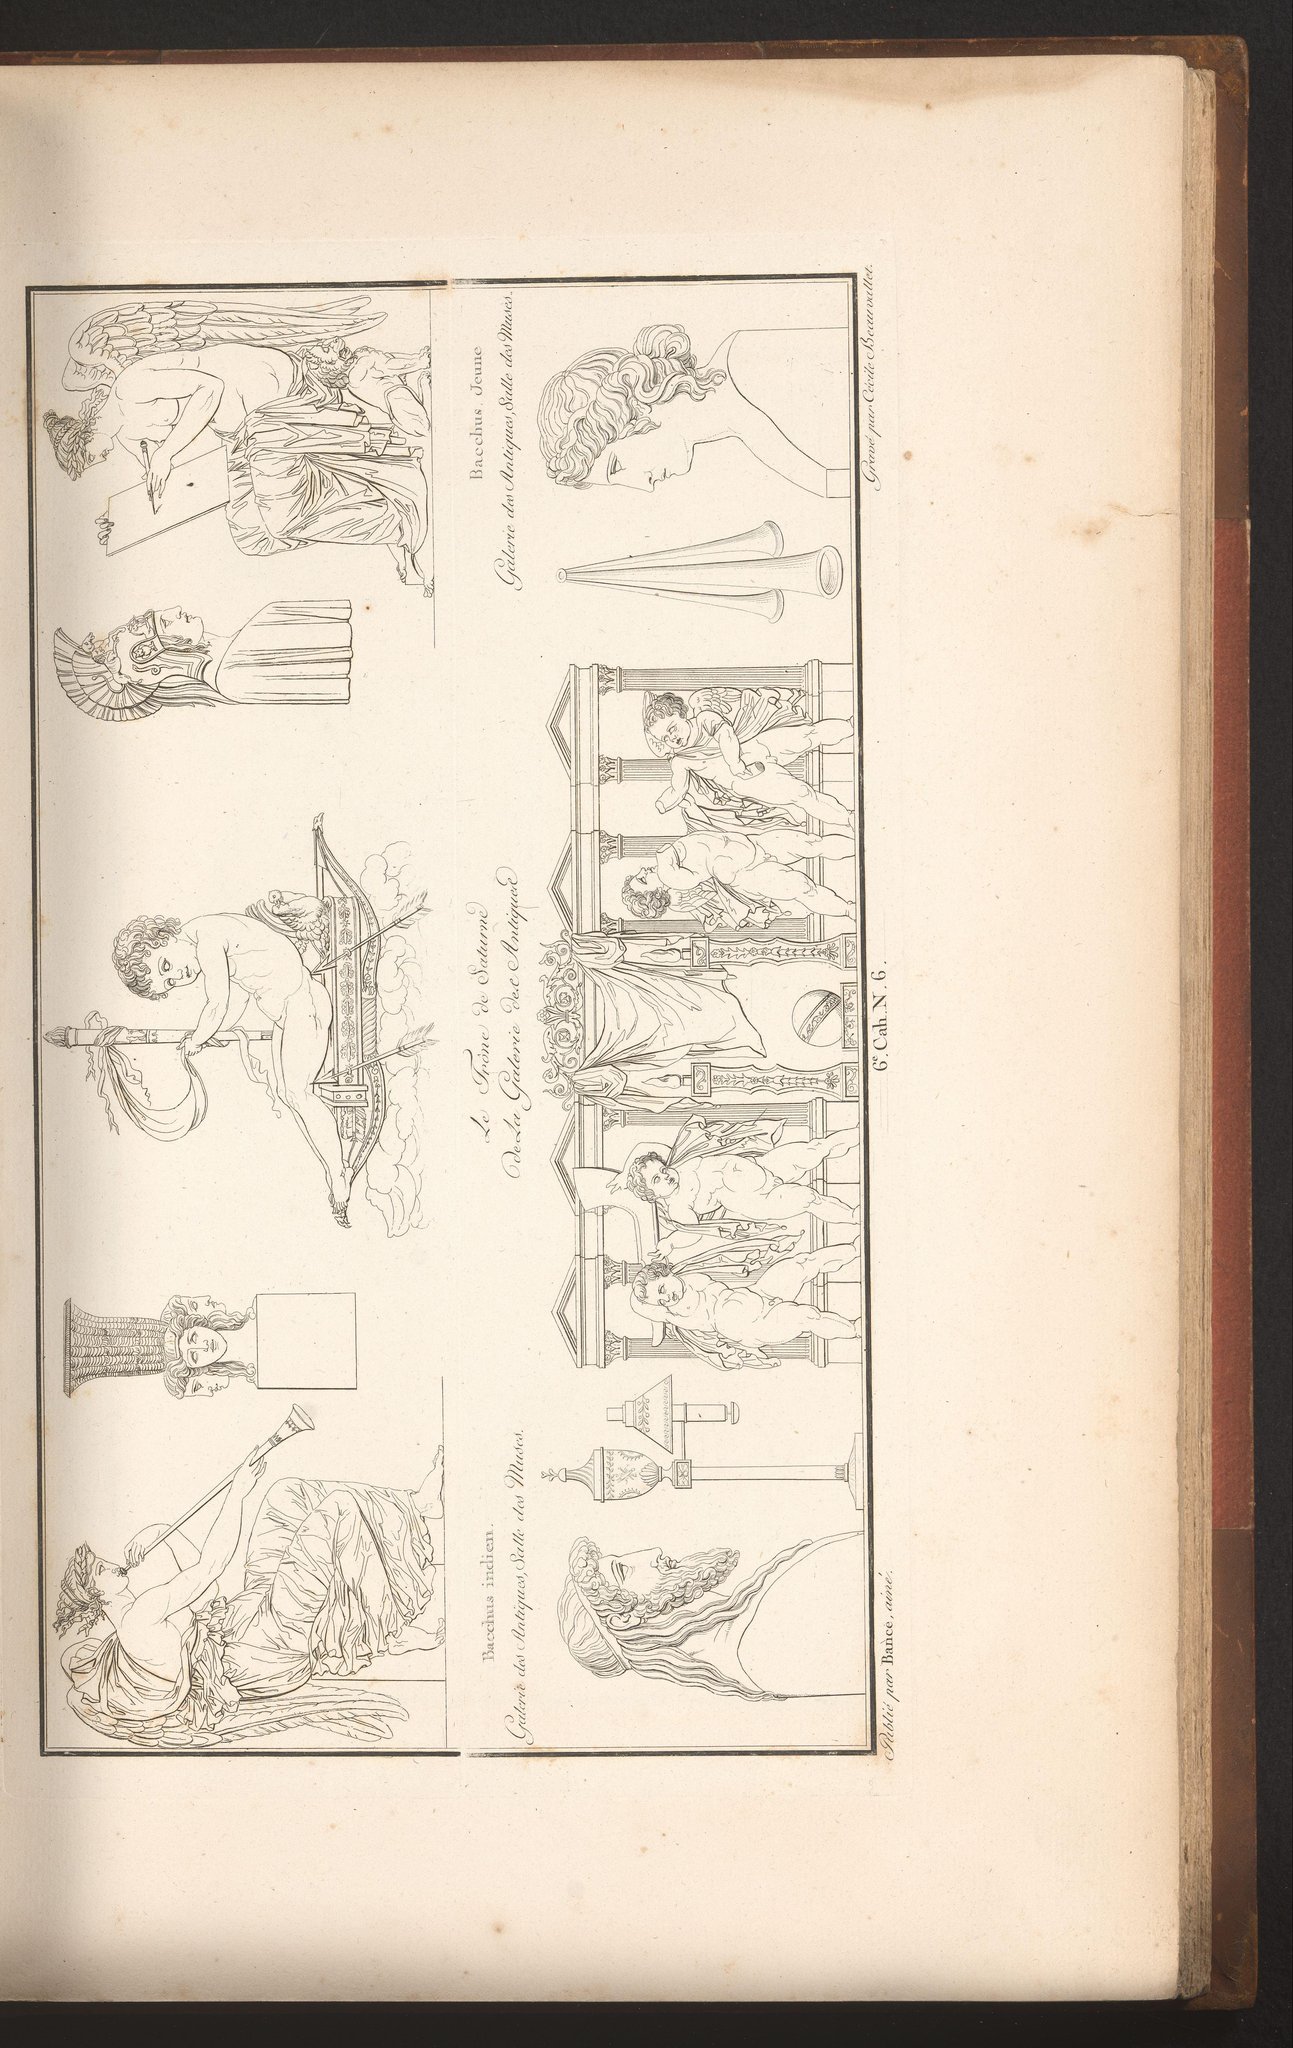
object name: ornament print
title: Reliëfsculpturen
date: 1820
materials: paper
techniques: etching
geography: paris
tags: ornaments ~ art, piece of sculpture, reproduction of a piece of sculpture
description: Ornamentprent met Romeinse reliëfsculpturen, centraal de 'Troon van Saturnus' in het Louvre. Onderdeel (6e. Cah. N. 6) van het prentalbum met twee series van in totaal 138 ornamentprenten door Beauvallet en Normand, 'Fragmens d'Ornemens dans le Style Antique'.